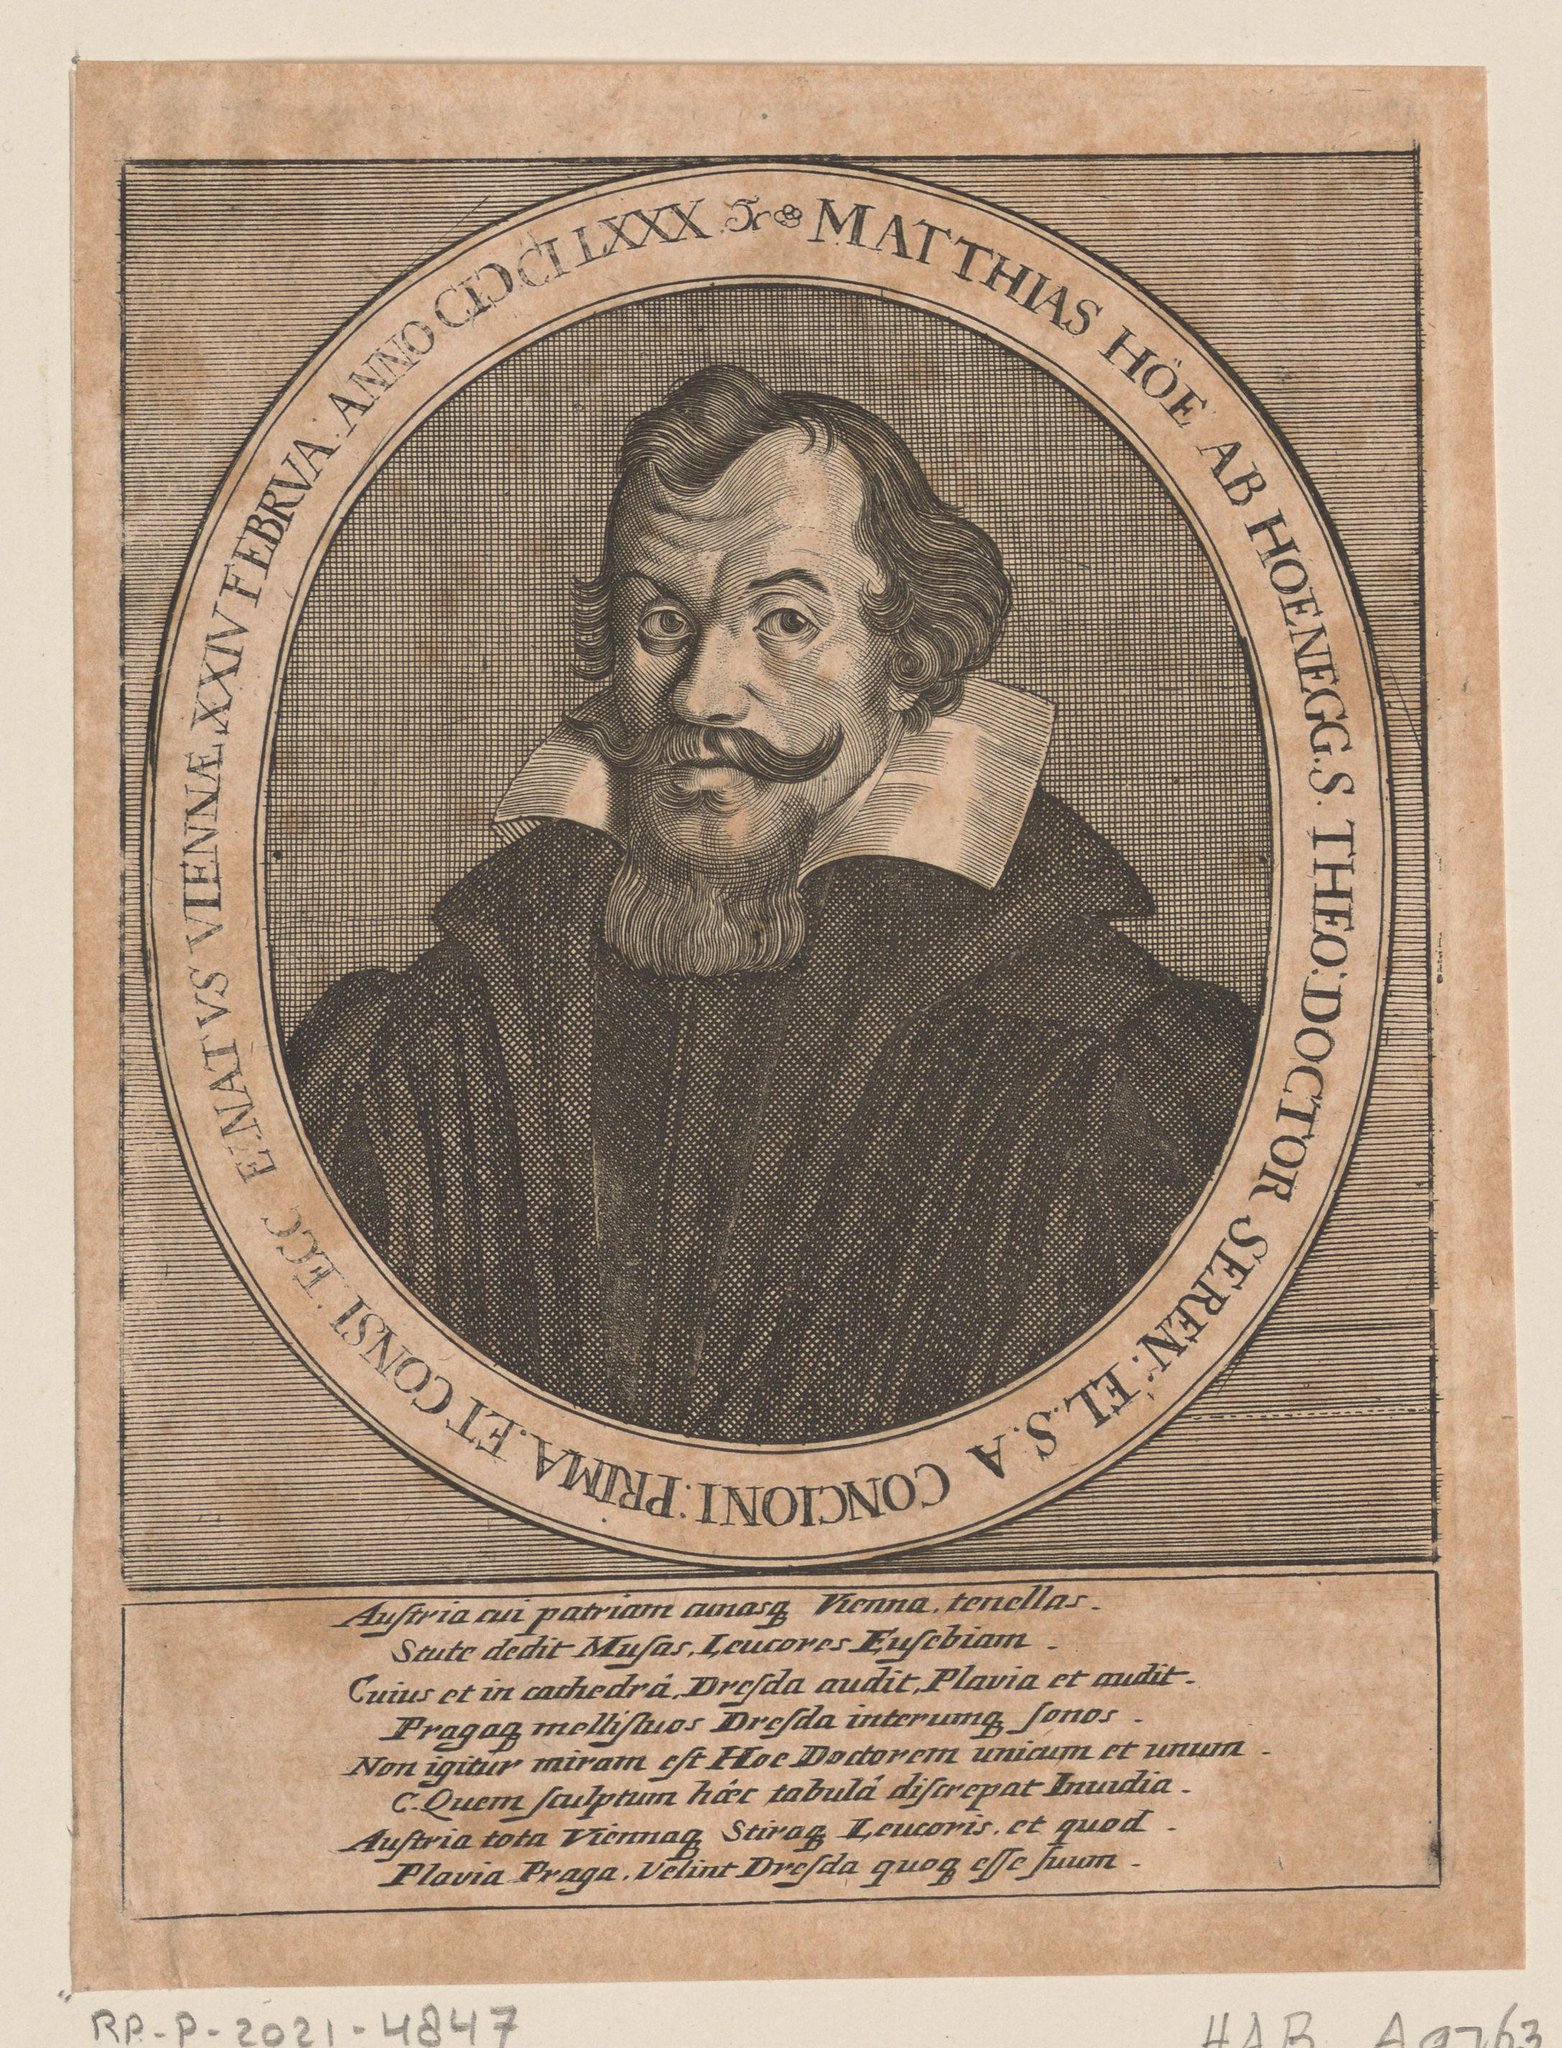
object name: print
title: Portret van Matthias Hoë von Hoënegg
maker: Anonymous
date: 1650-1699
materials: paper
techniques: engraving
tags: vienna, theologian, historical persons